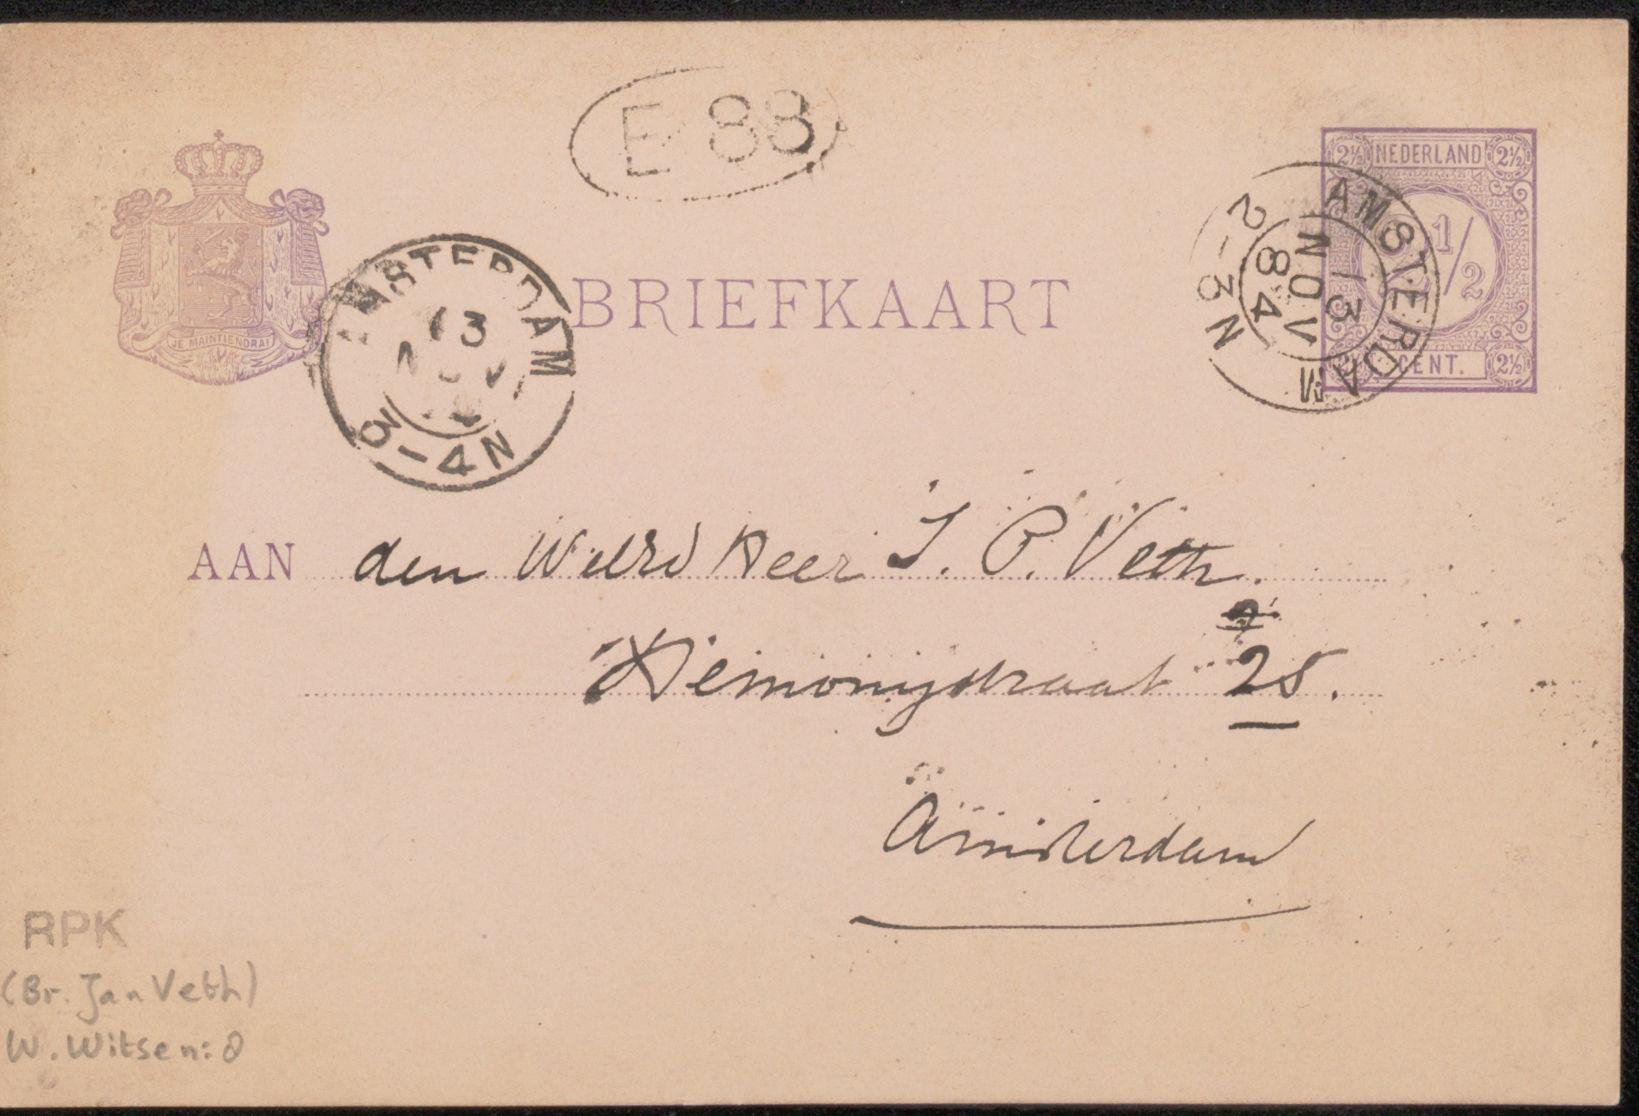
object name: postcard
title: Briefkaart aan Jan Veth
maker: willem witsen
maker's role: draughtsman, painter, print maker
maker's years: 1860-1923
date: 1884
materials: cardboard, ink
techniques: pen, writing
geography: ewijkshoeve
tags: dordrecht, amsterdam, painter, print maker, draughtsman, designer, jan veth, frank van der goes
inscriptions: collector's mark: ‘RPK’